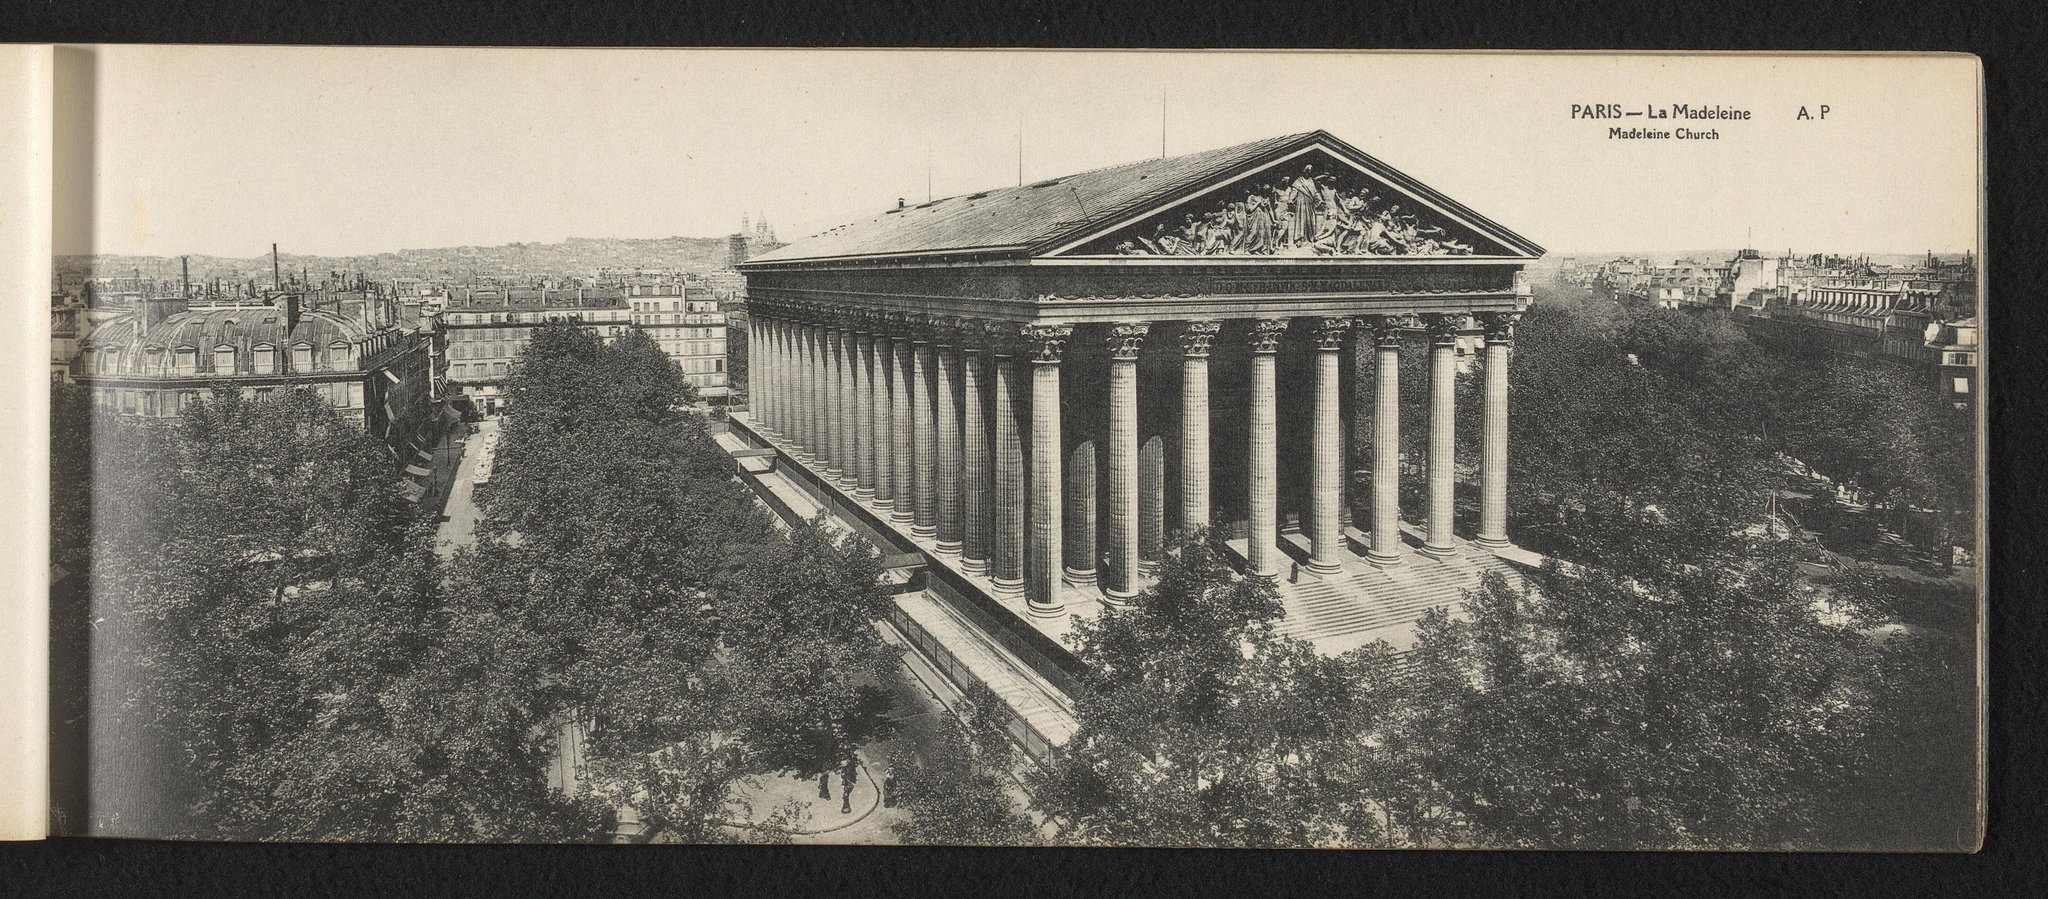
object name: photomechanical print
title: Paris. La Madeleine / Madeleine Church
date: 1910-1925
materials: cardboard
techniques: photograph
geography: paris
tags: church (exterior), city-view, and landscape with man-made constructions (+ city(-scape) with figures, staffage)